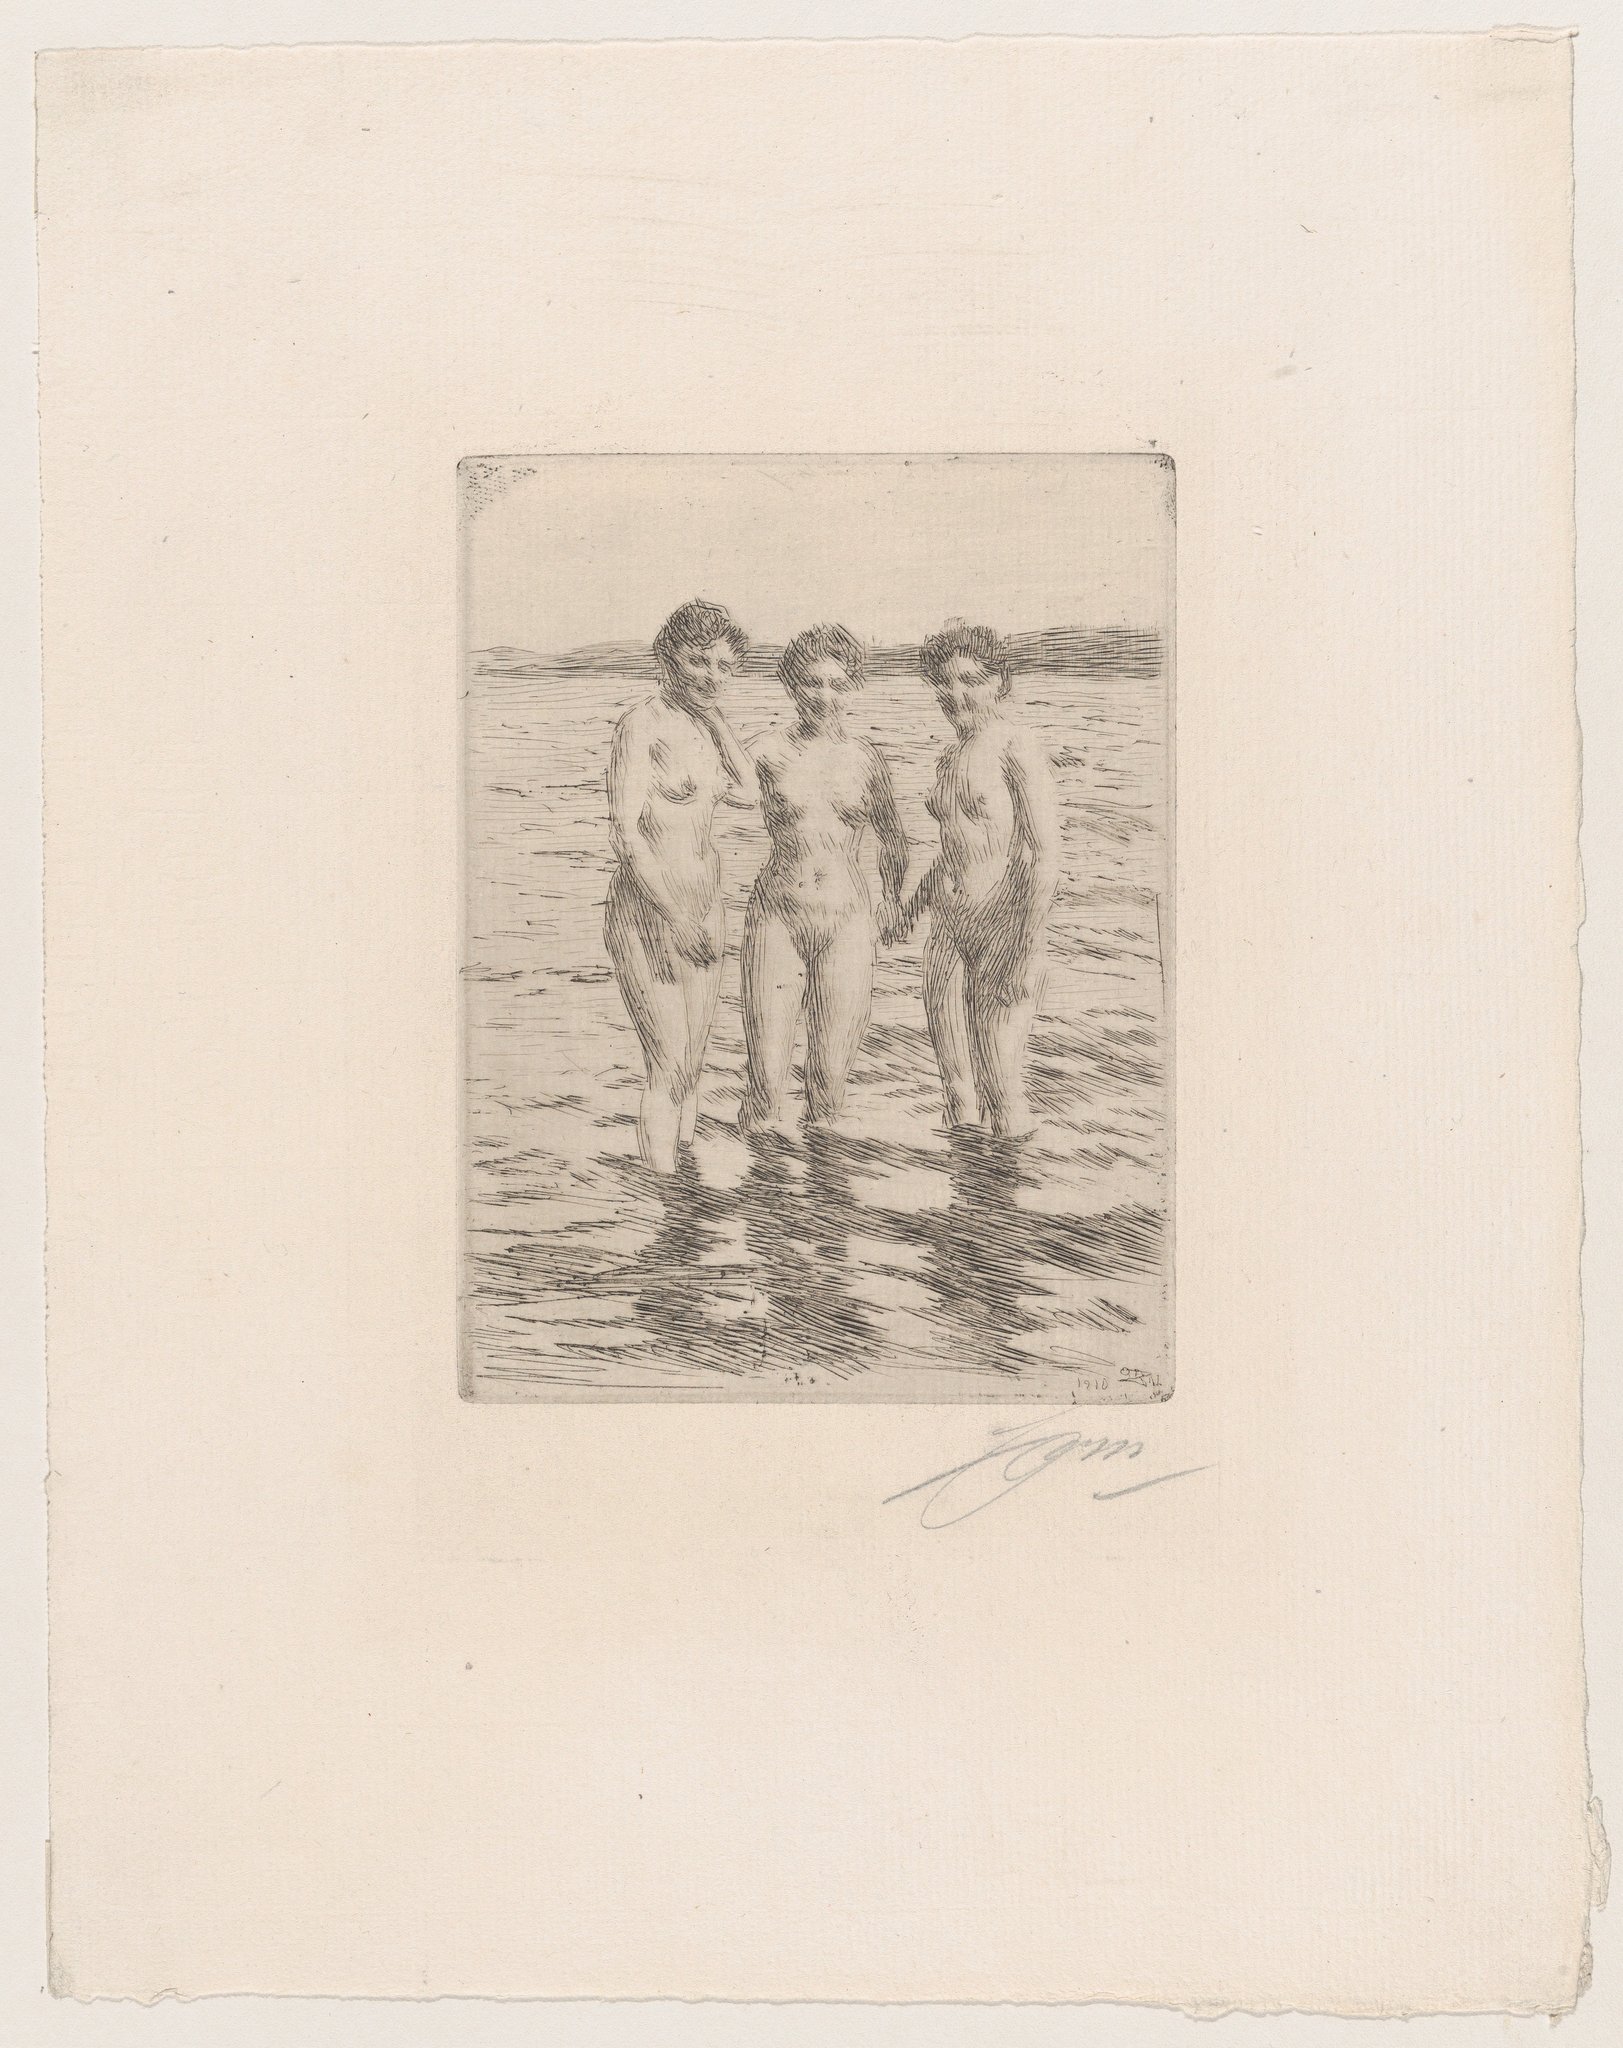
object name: print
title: The Three Graces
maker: anders zorn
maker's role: artist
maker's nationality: swedish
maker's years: 1860-1920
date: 1910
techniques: etching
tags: female nudes